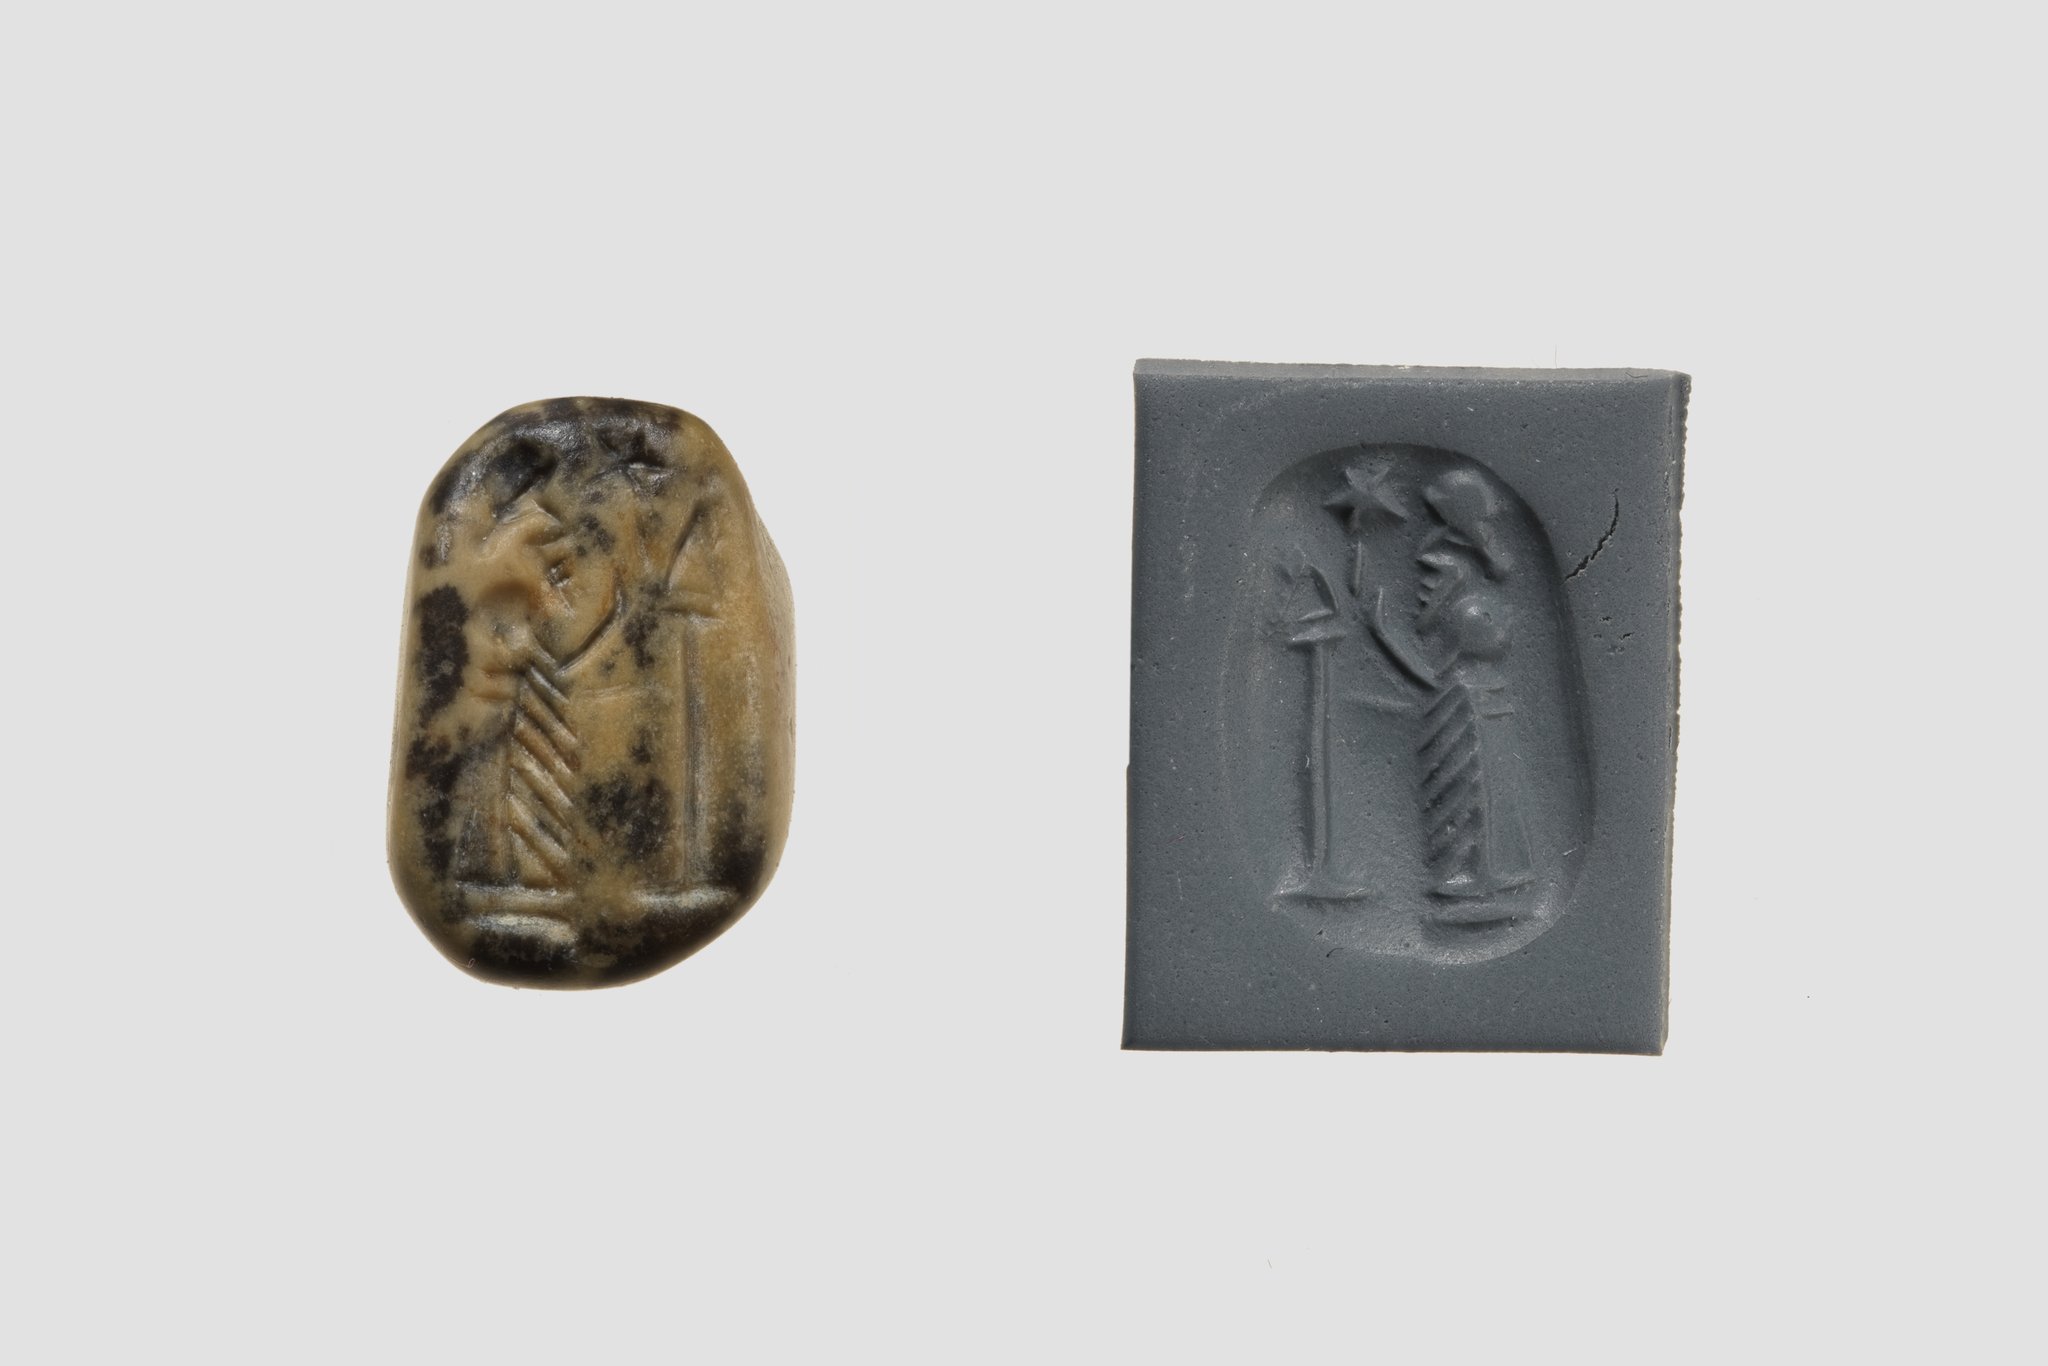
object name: stamp seal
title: Stamp seal (octagonal pyramid, worn) with cultic scene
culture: assyrian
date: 734-601 BCE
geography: mesopotamia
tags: men